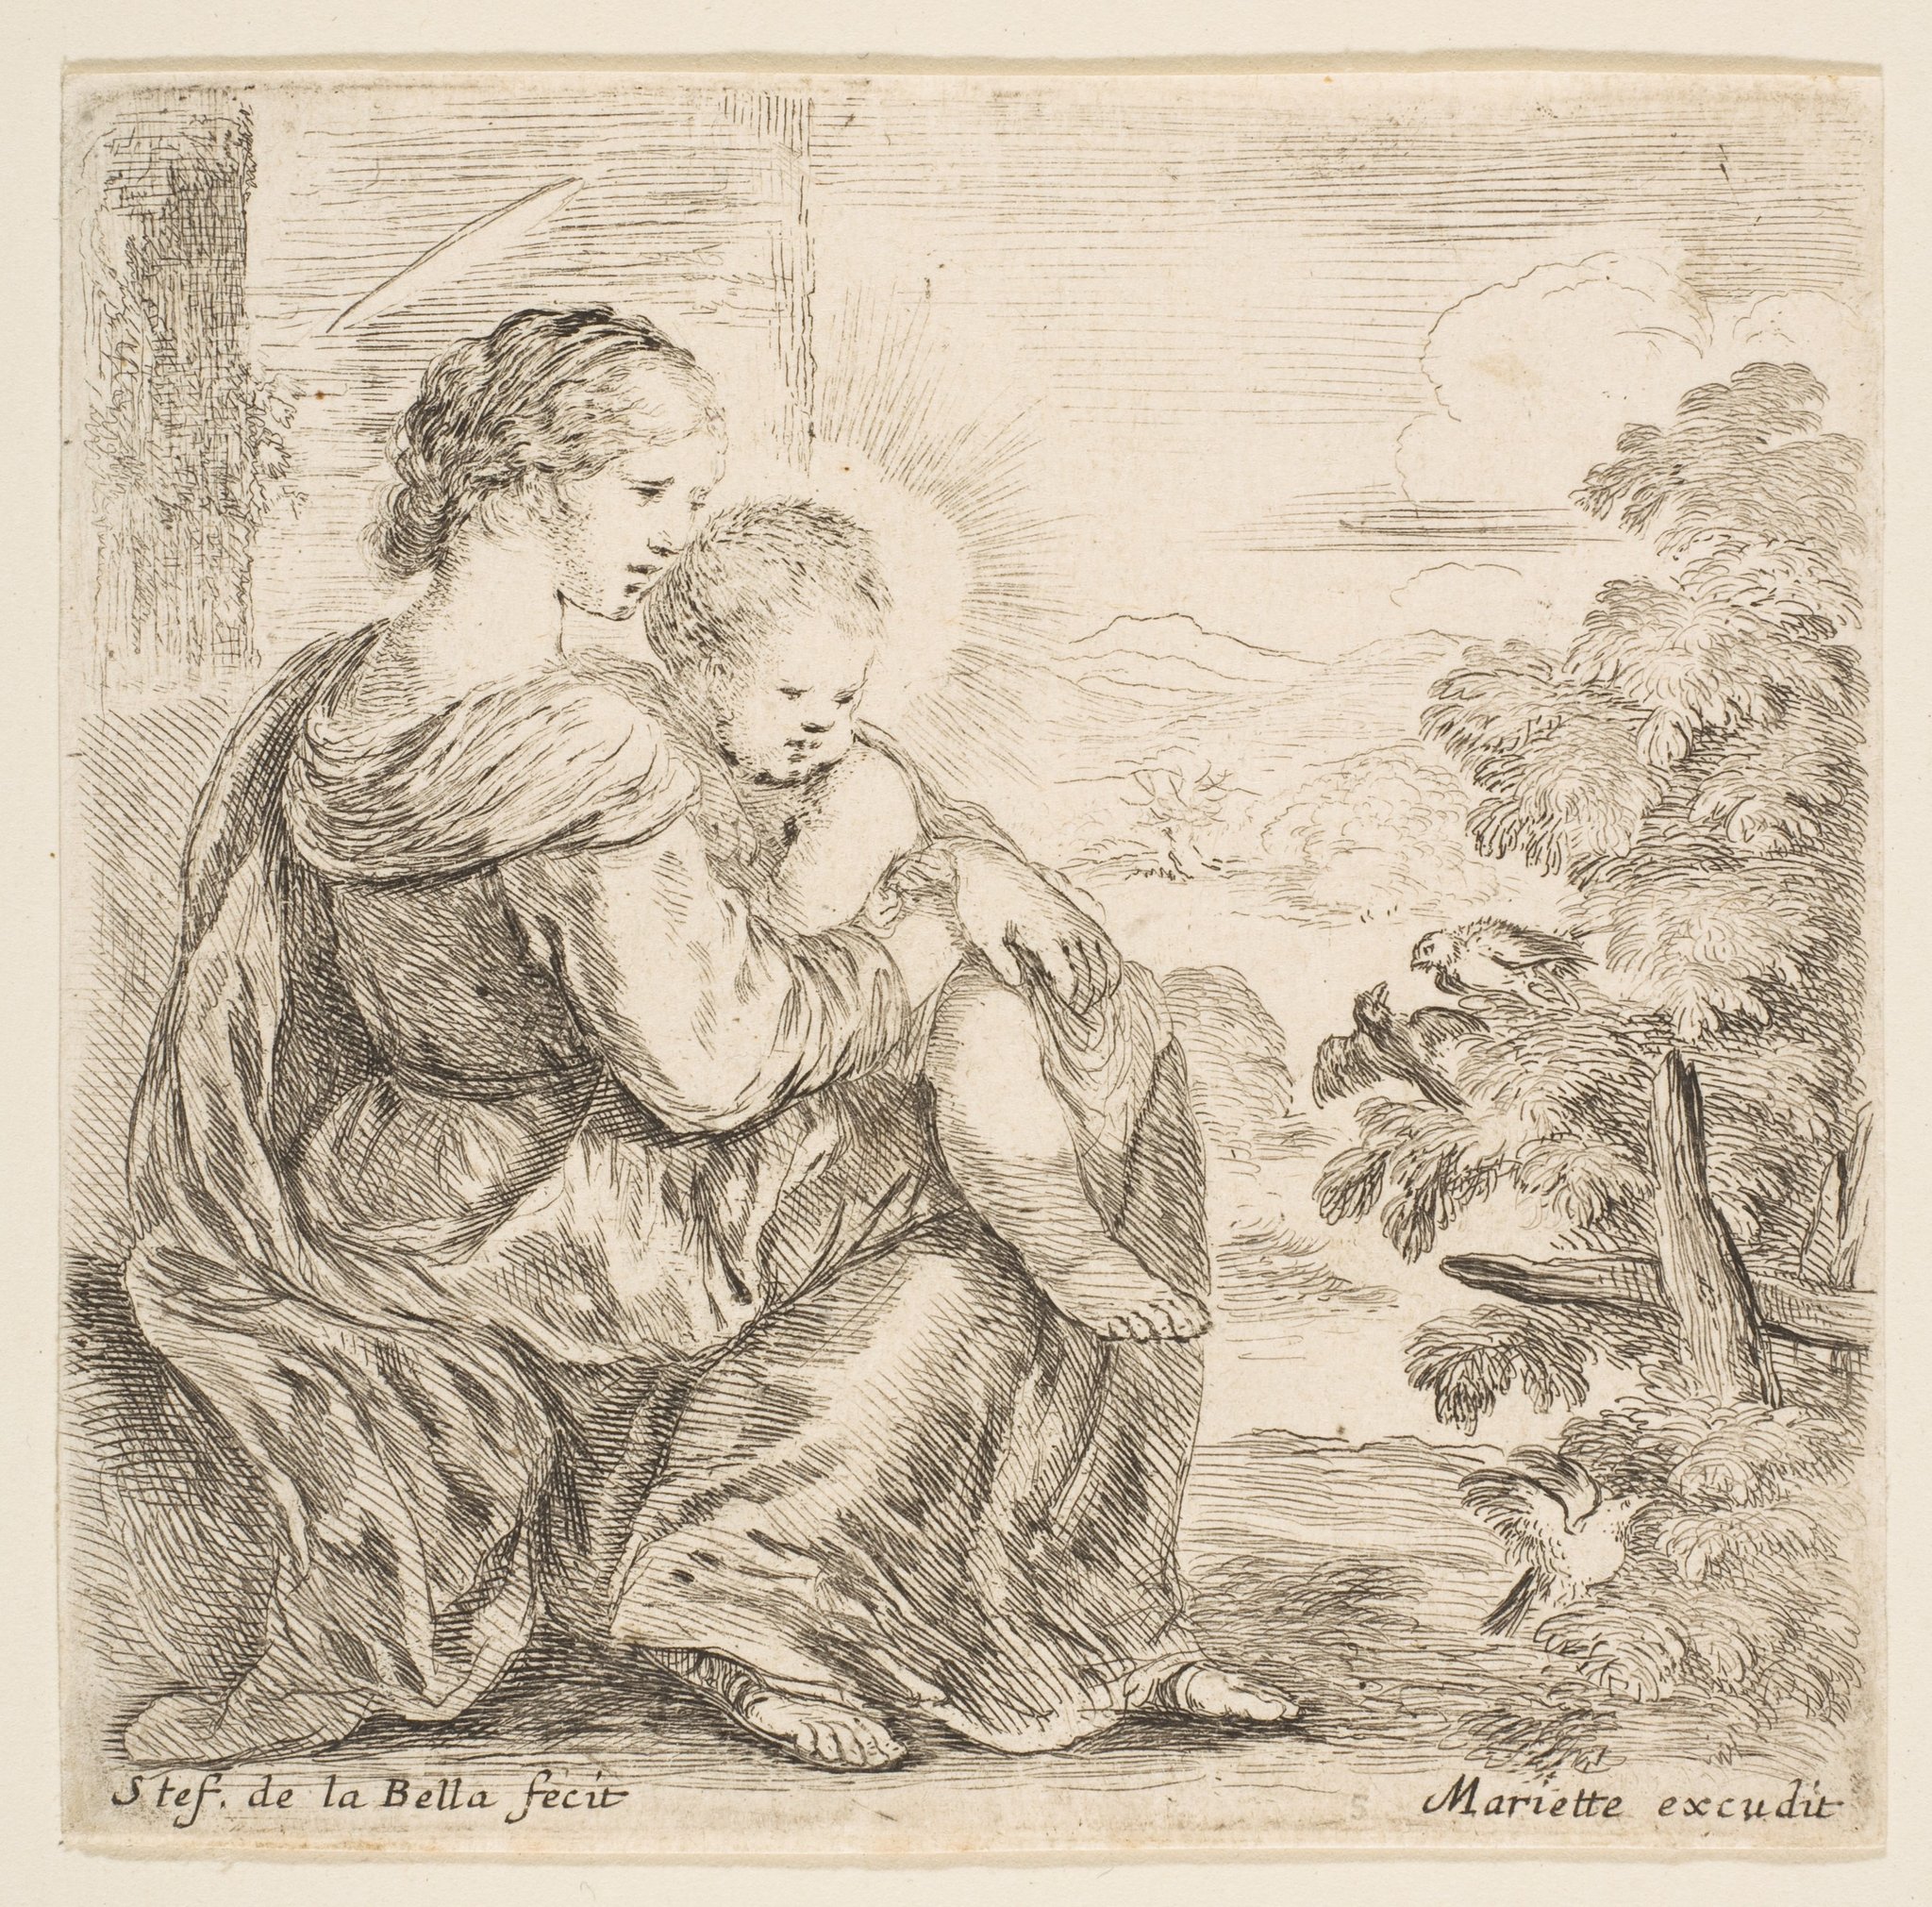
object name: print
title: Virgin and Christ Child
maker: stefano della bella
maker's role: artist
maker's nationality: italian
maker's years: 1610-1664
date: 1641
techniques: etching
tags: madonna and child